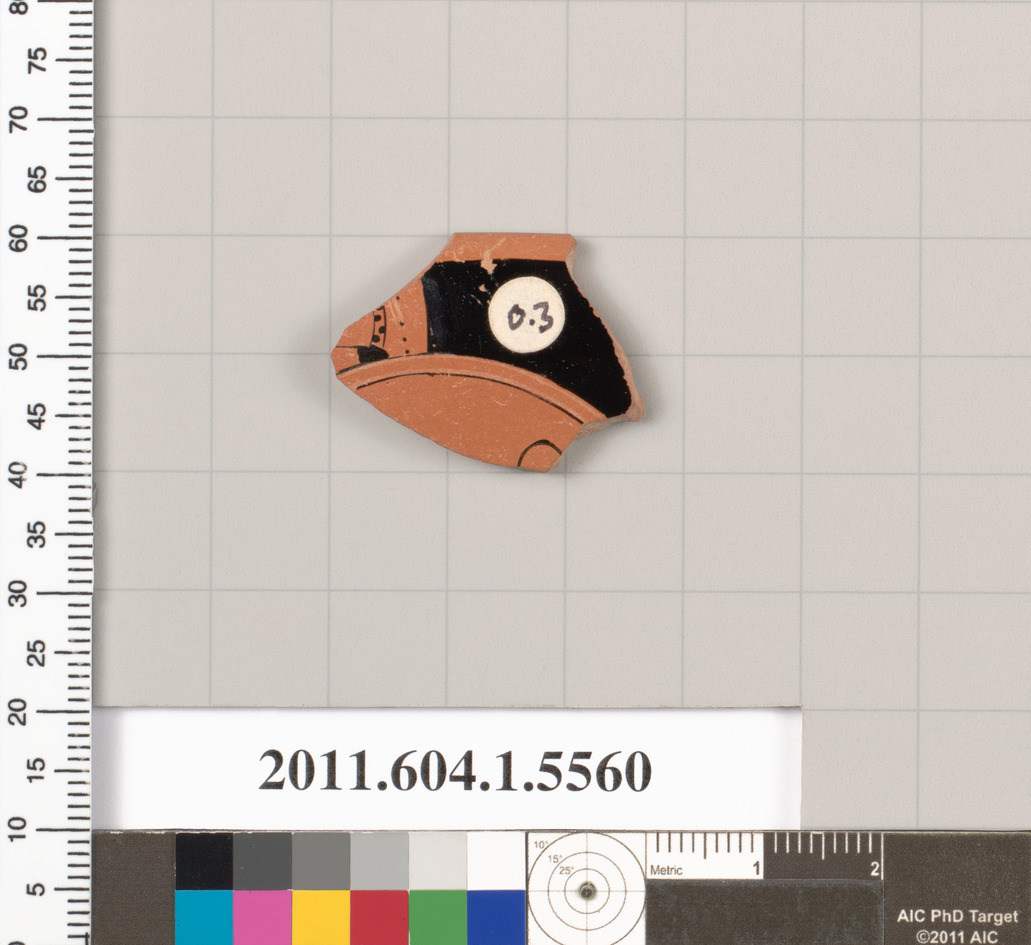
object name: kylix fragment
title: Terracotta rim fragment of a kylix (drinking cup)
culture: greek, attic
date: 520-500 BCE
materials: terracotta